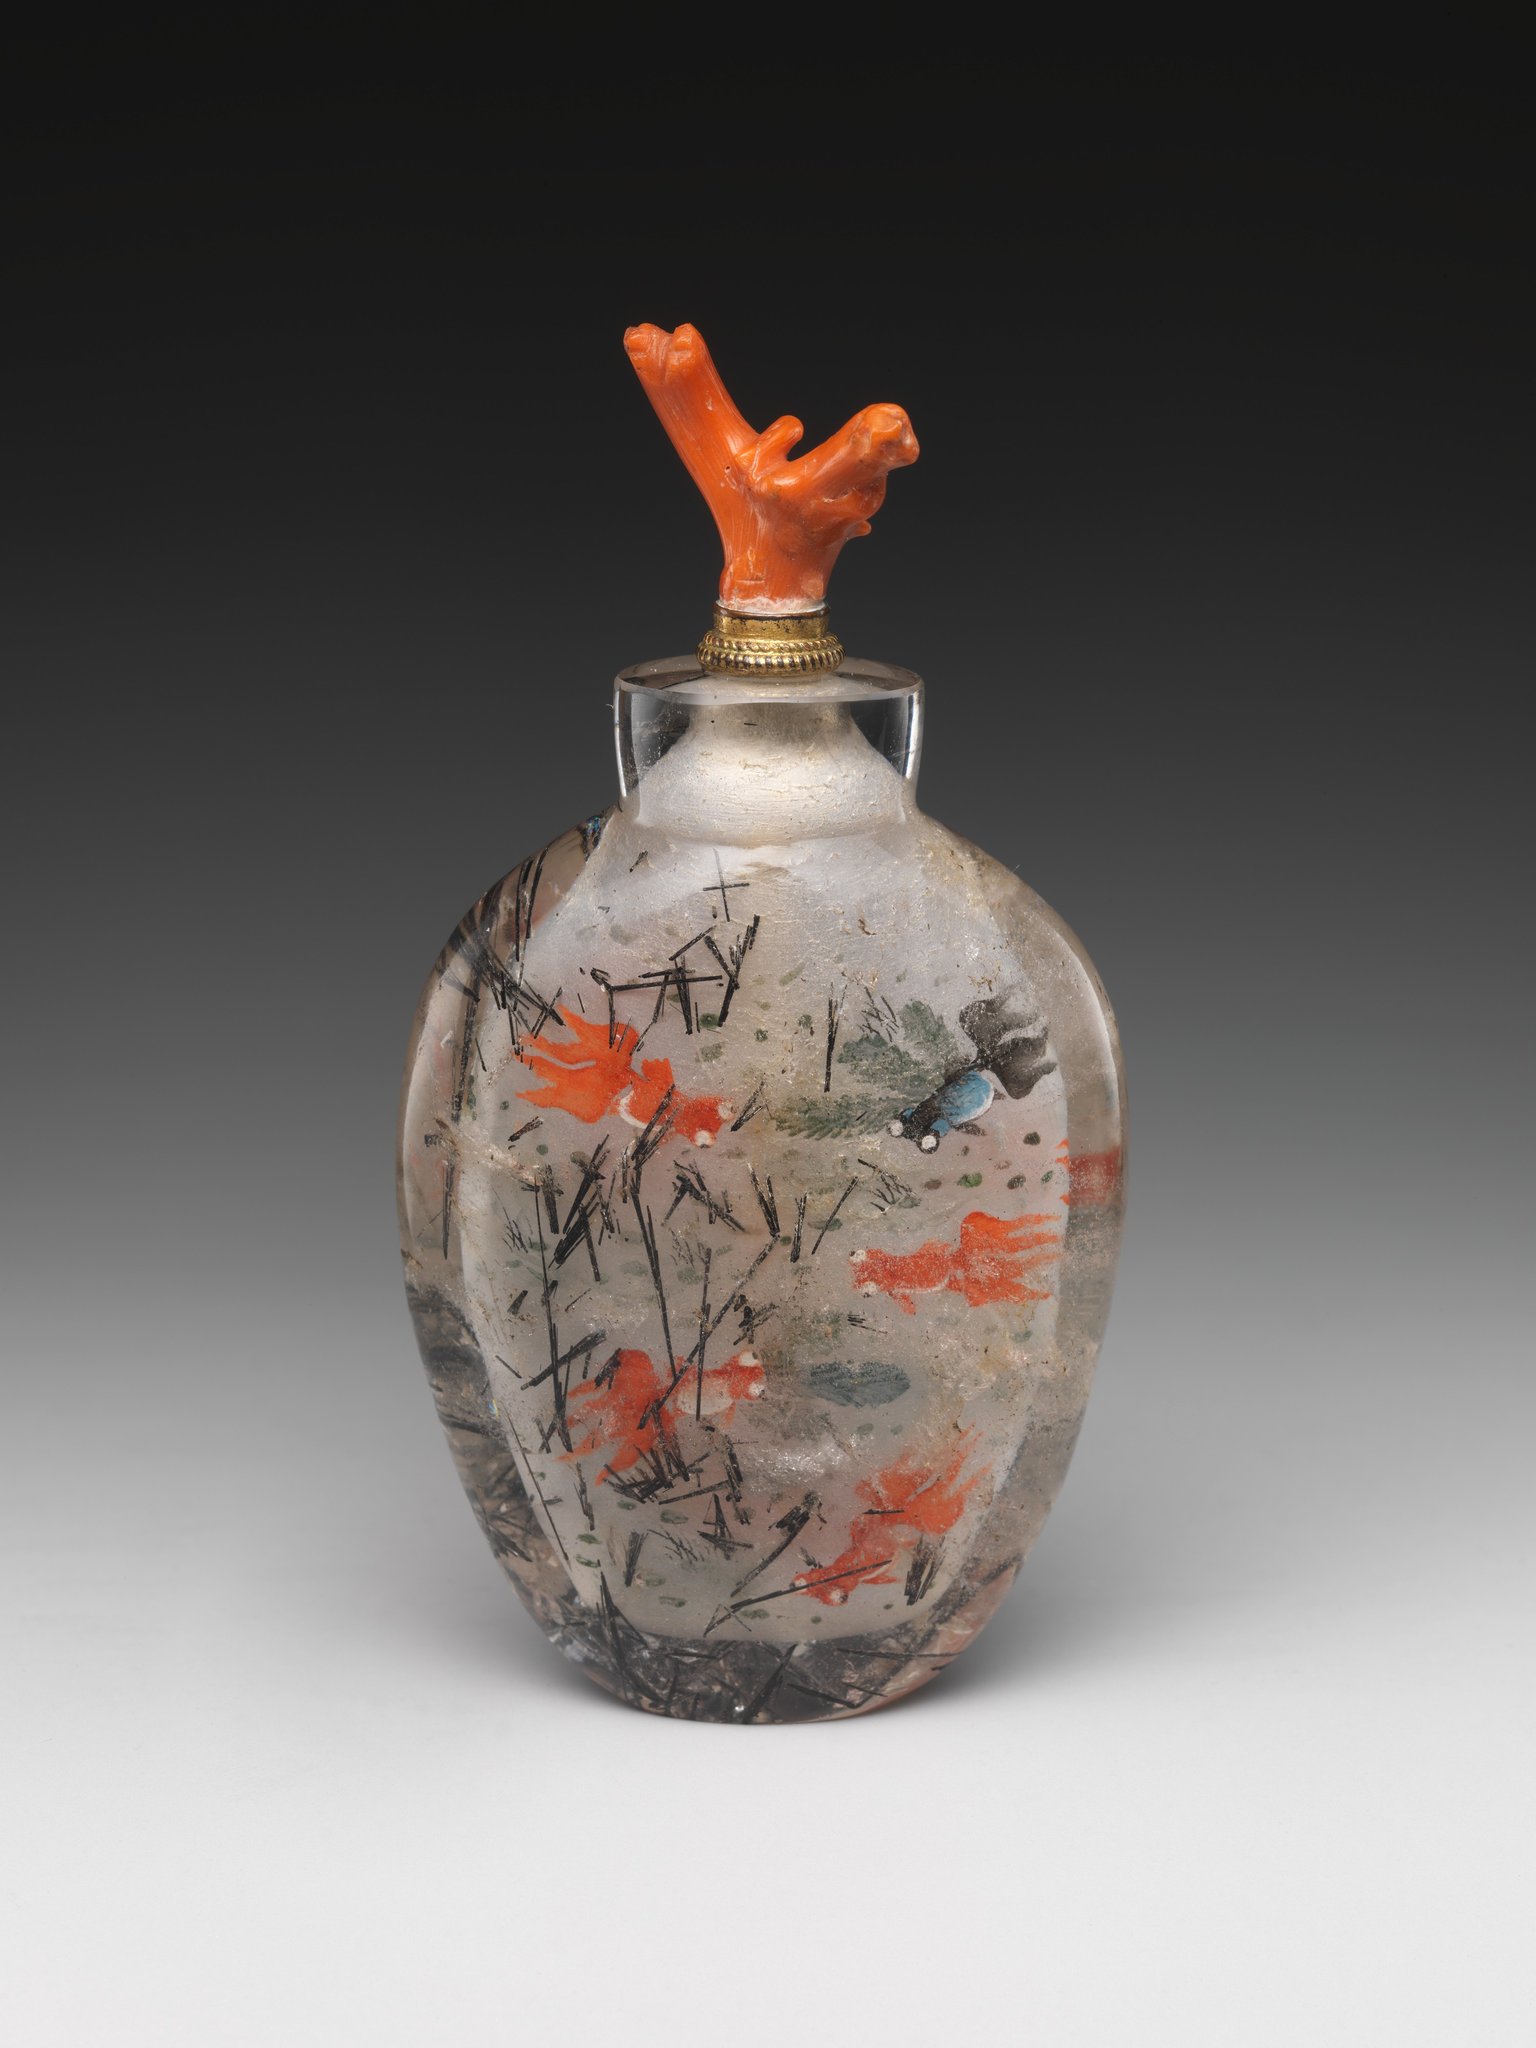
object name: snuff bottle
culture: chinese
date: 1801-1900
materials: coral, crystal, hair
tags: fish